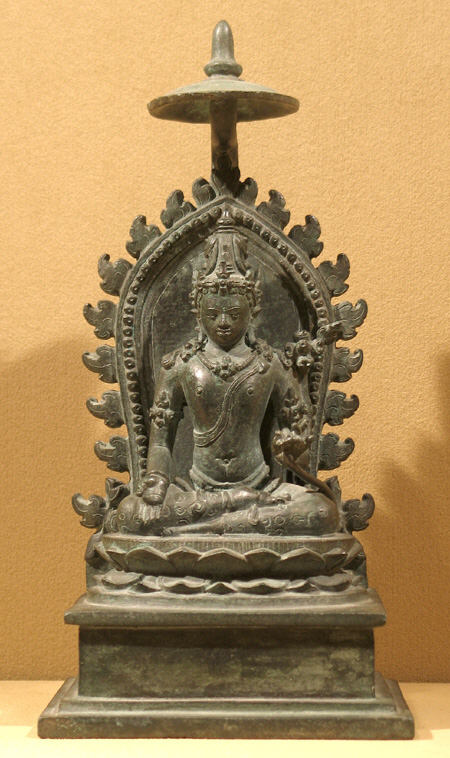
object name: sculpture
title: Seated Bodhisattva Maitreya, the Buddha of the Future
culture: indonesian, javanese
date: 801-900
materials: bronze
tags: buddhism,bodhisattvas,maitreya